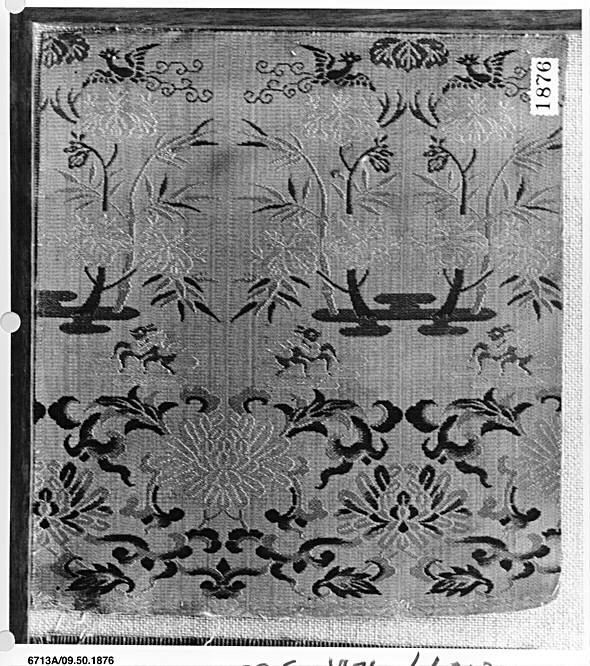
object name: piece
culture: japanese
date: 1615-1868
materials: metal thread, silk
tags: birds,trees